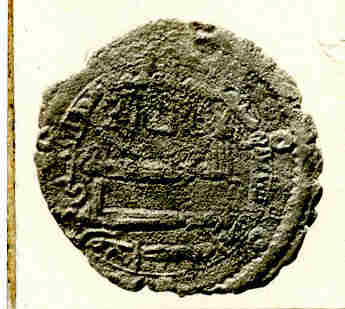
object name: coin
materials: copper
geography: iran